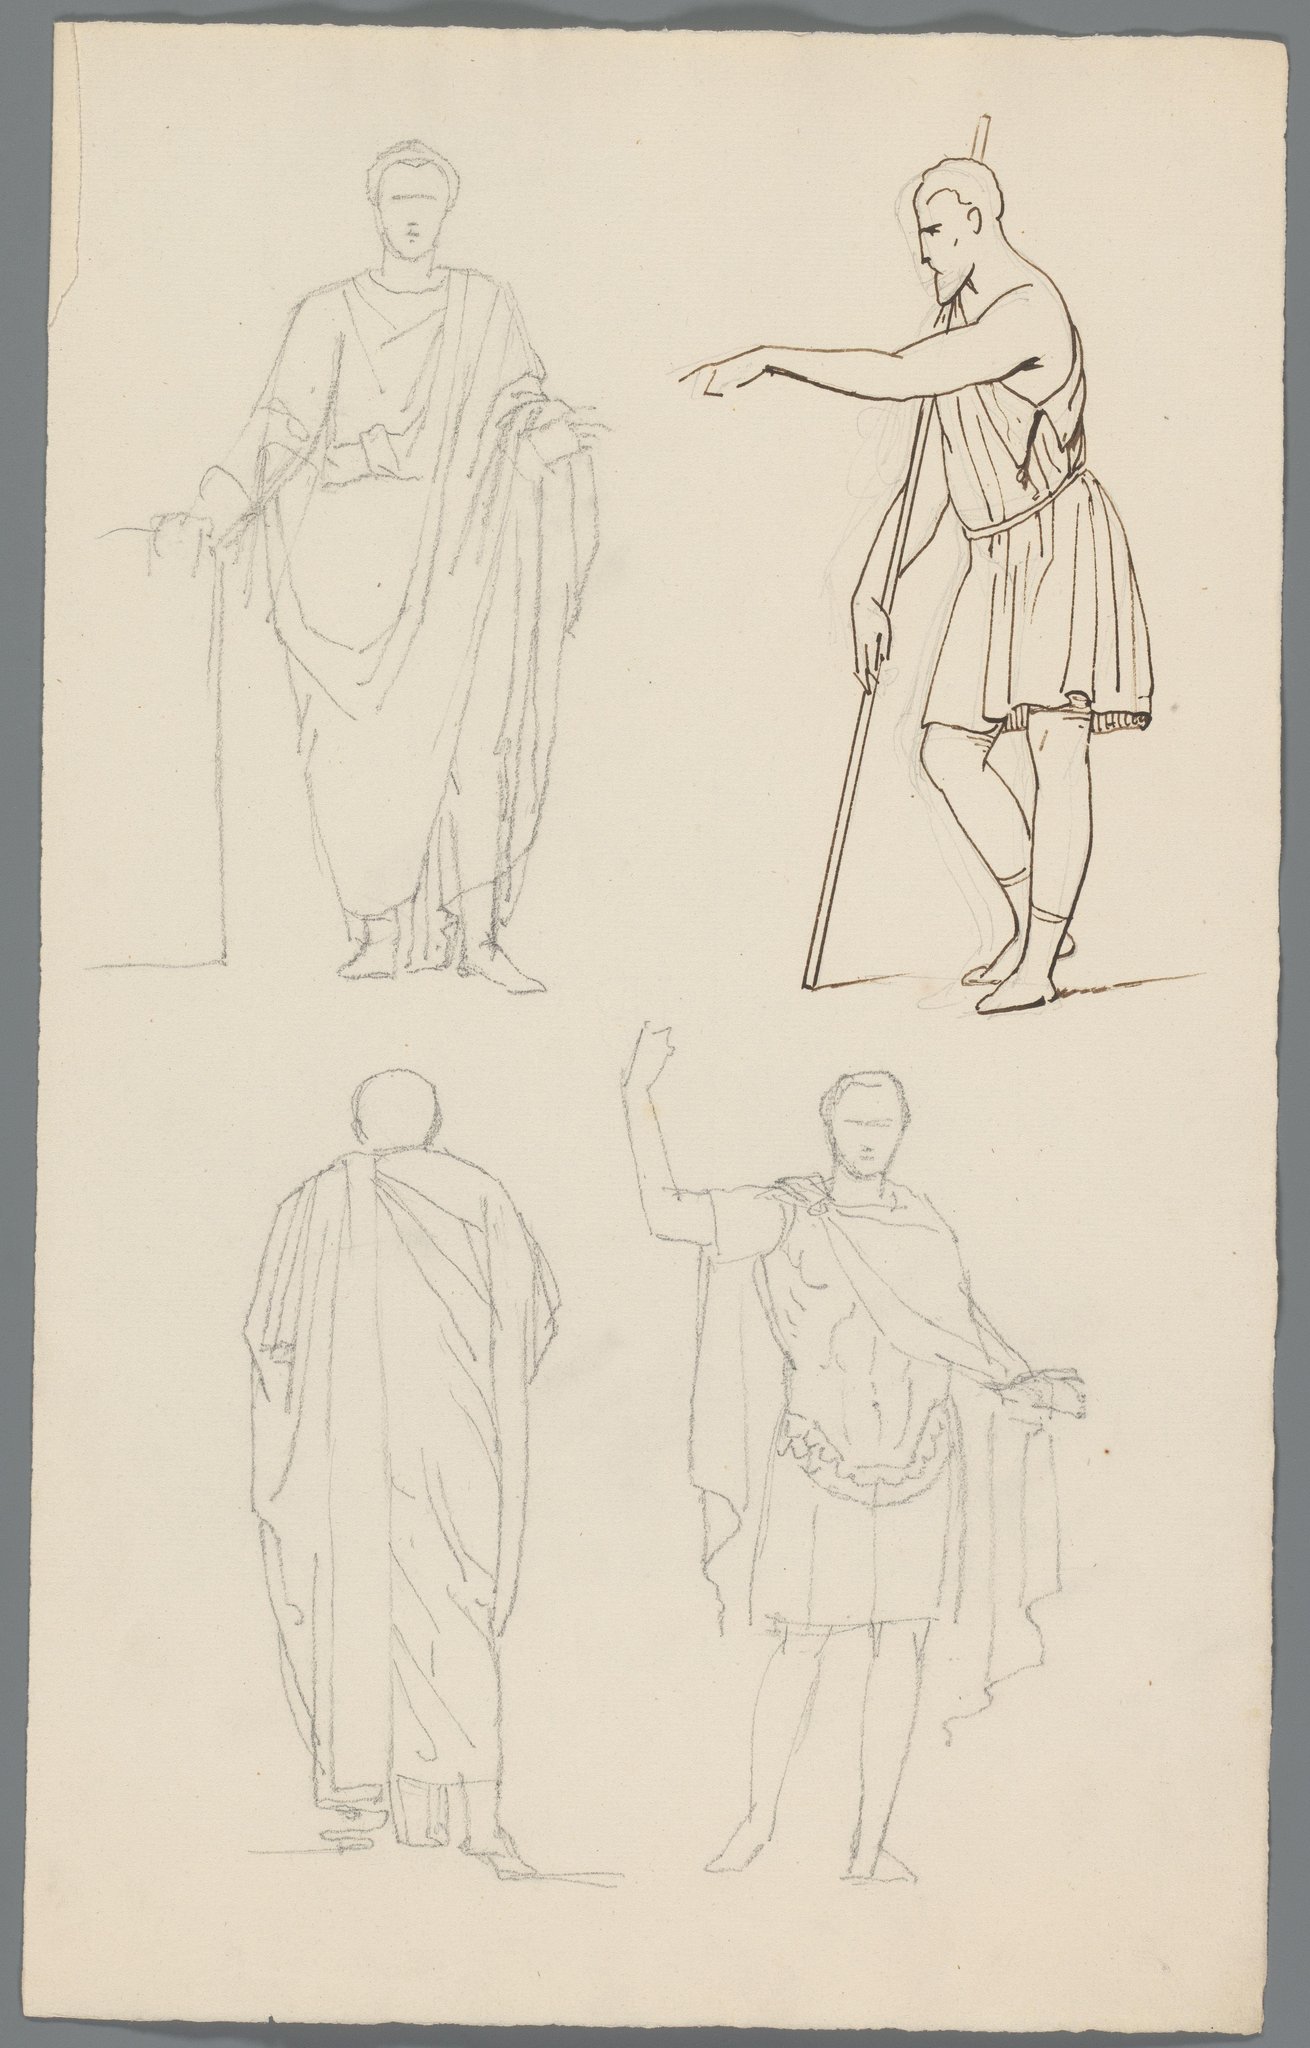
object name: drawing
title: Studies van mannen in toga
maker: jacobus everhardus josephus van den berg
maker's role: draughtsman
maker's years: 1802-1861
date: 1812-1861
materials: ink, paper, pencil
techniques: pen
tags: standing figure (canon, proportions)